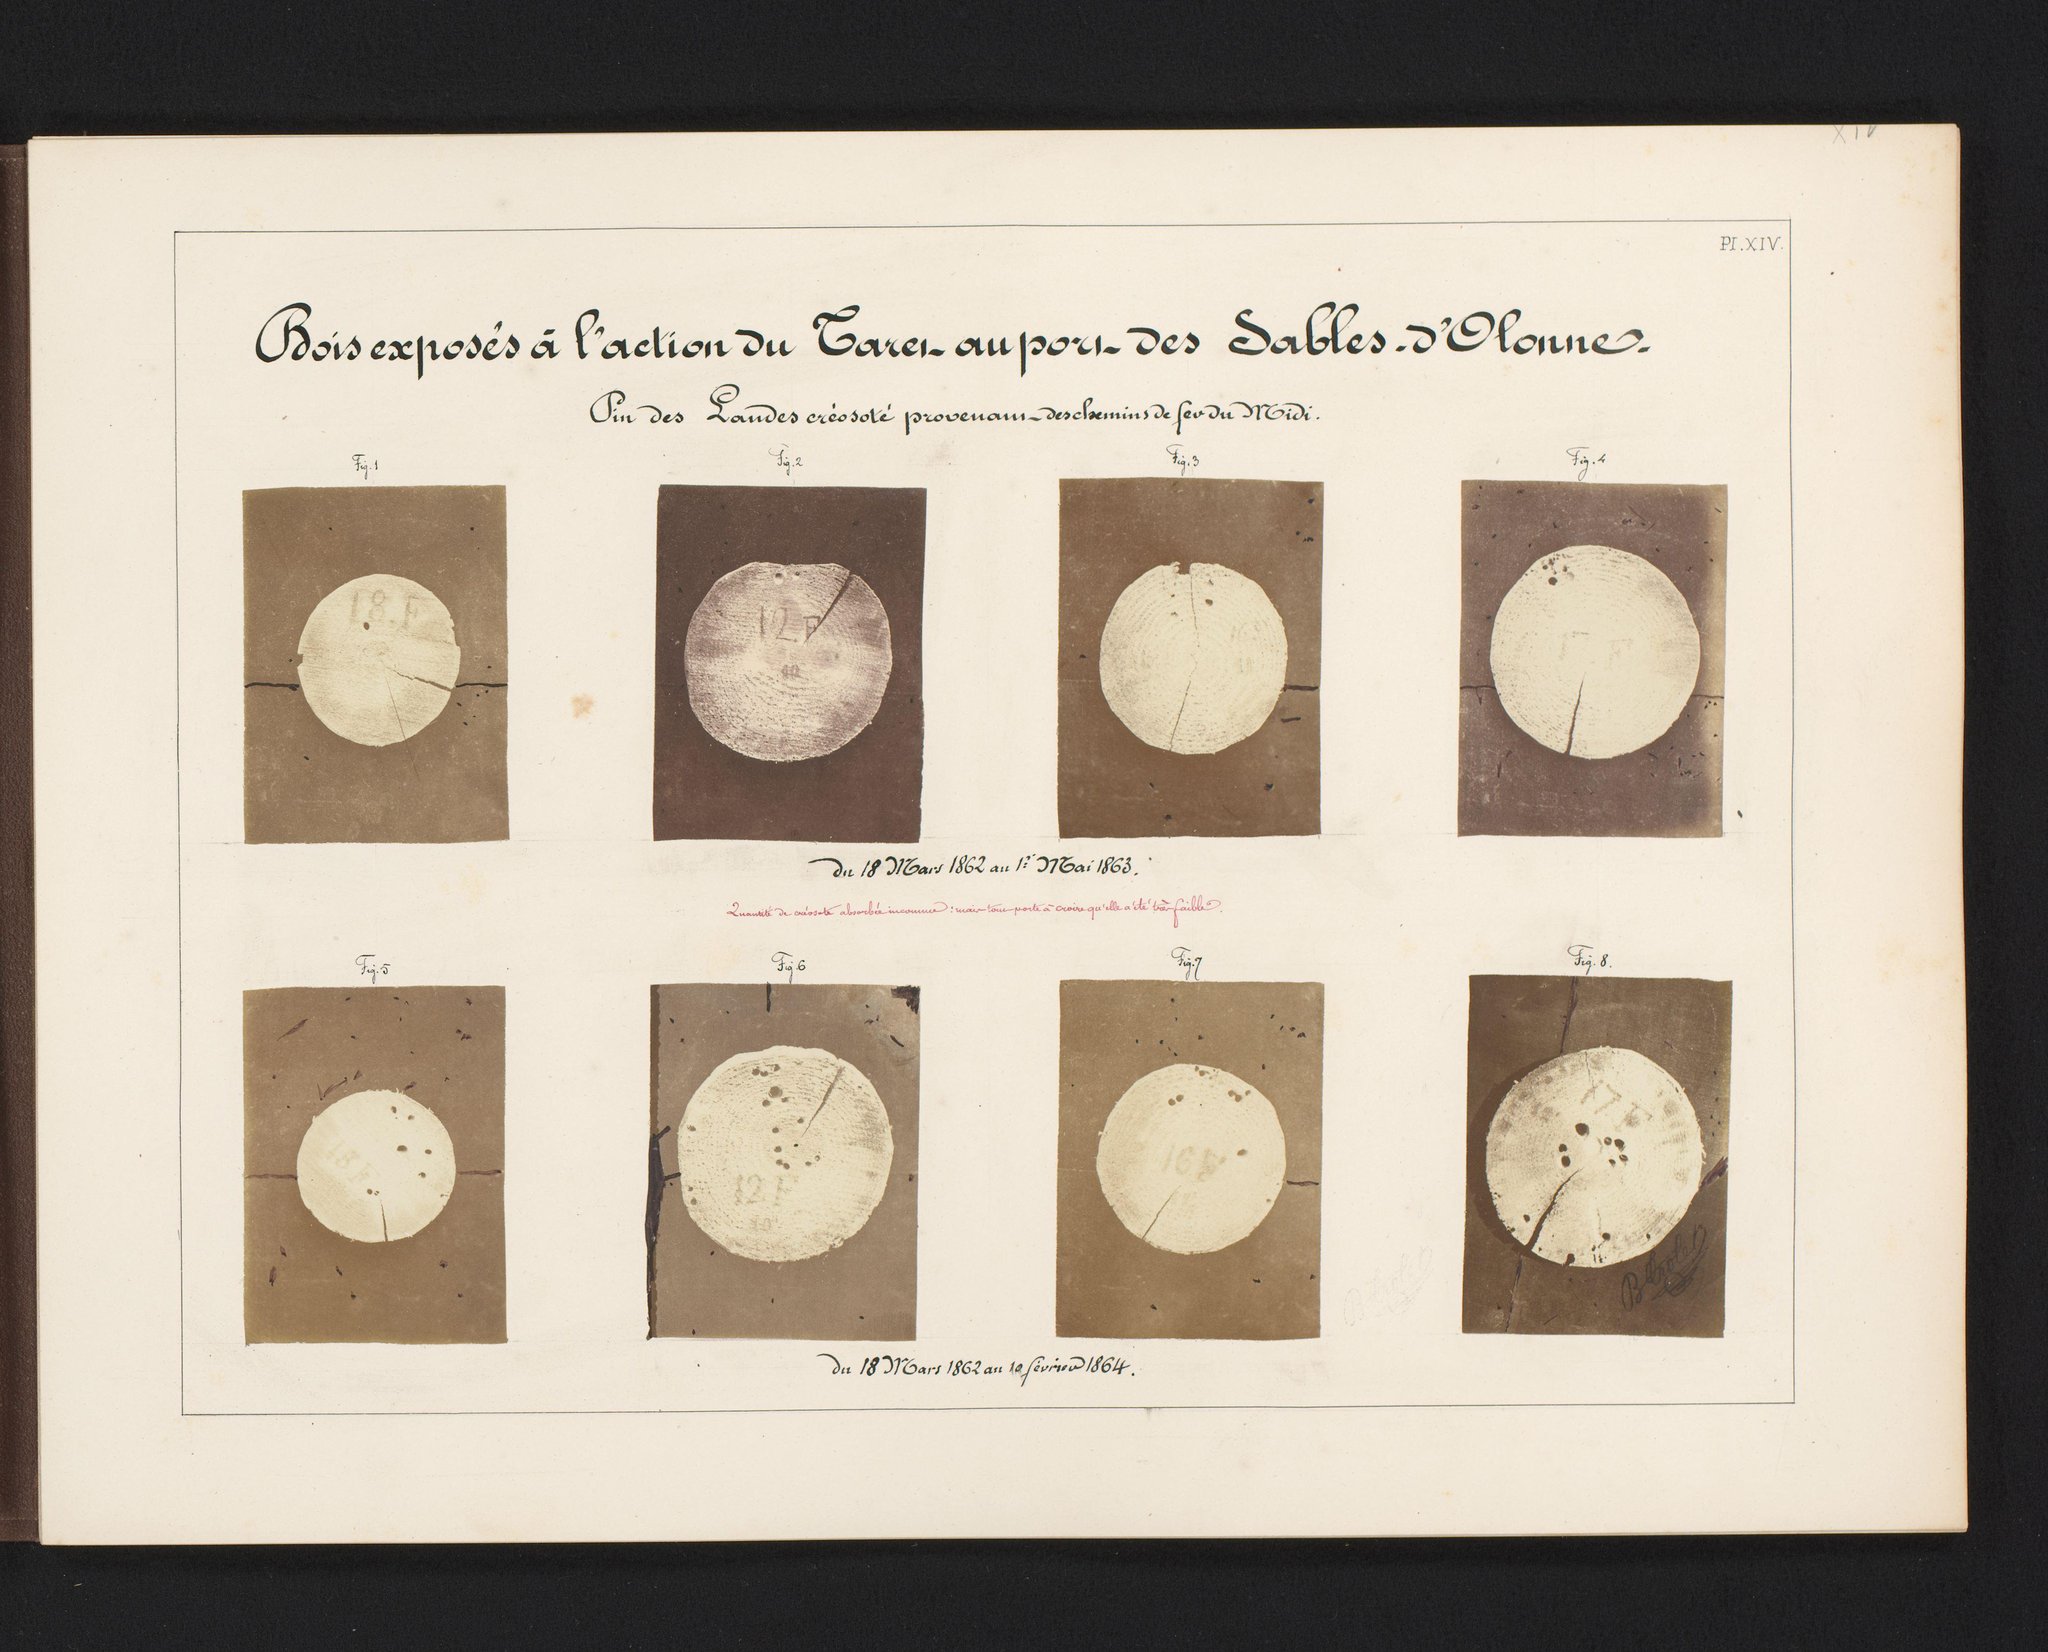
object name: photograph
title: Bois exposés à l'action du Taret au port des Sables-d'Olonne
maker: b. crolet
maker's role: fotograaf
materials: cardboard, photographic support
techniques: albumen print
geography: france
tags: worms, wood, timber ~ building material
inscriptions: signature: ‘B. Crolet’, number: ‘Pl. XIV.’, annotation: ‘Pin des Landes crésoté provenant des chemins de feu du Midi (...) 10 février 1864.’